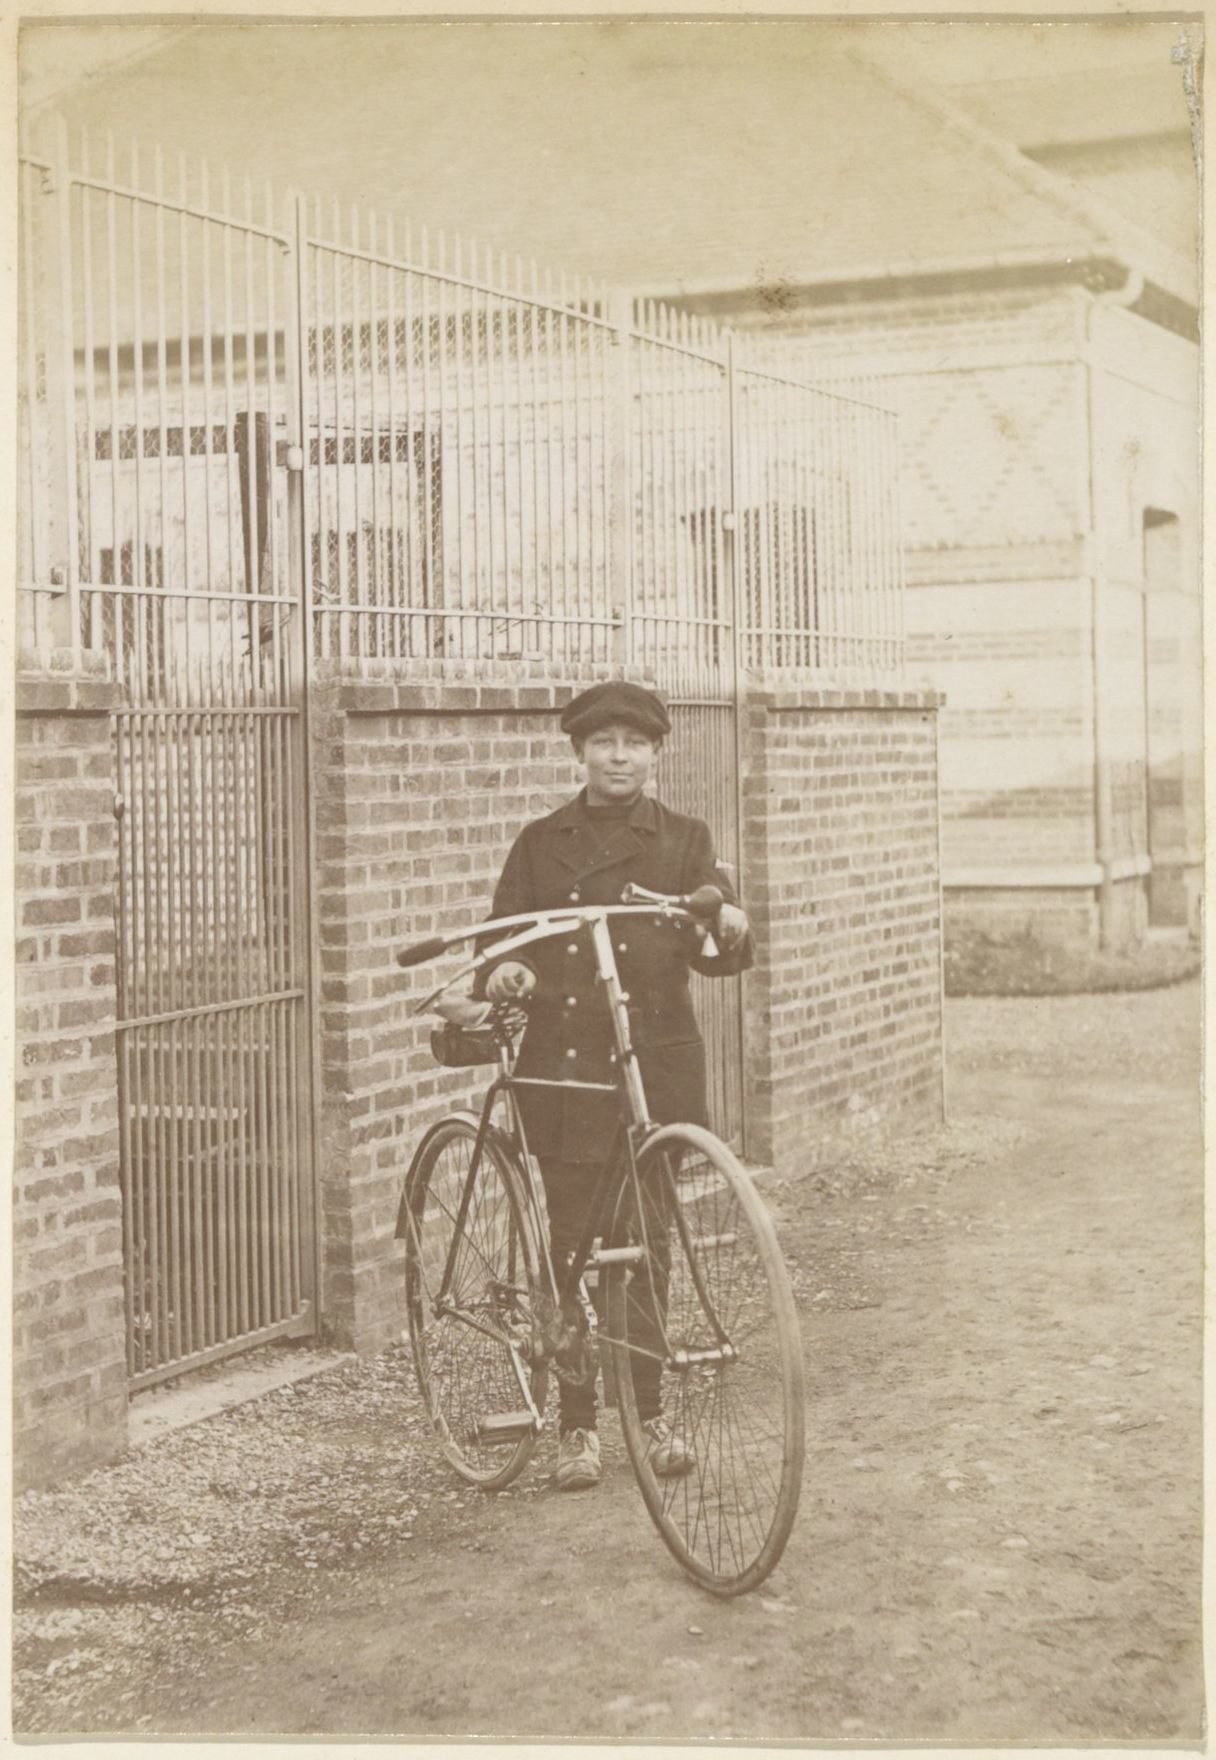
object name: photograph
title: Portret van een Franse meisje staand naast een fiets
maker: Anonymous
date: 1900-1910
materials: paper, photographic support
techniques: albumen print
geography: france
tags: youth, adolescent, bicycle, france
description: Onderdeel van Fotoalbum van een Franse amateurfotograaf met opnames van een familie, distilleerderij Delizy & Doistau Fils, het leger en bezienswaardigheden in Frankrijk.